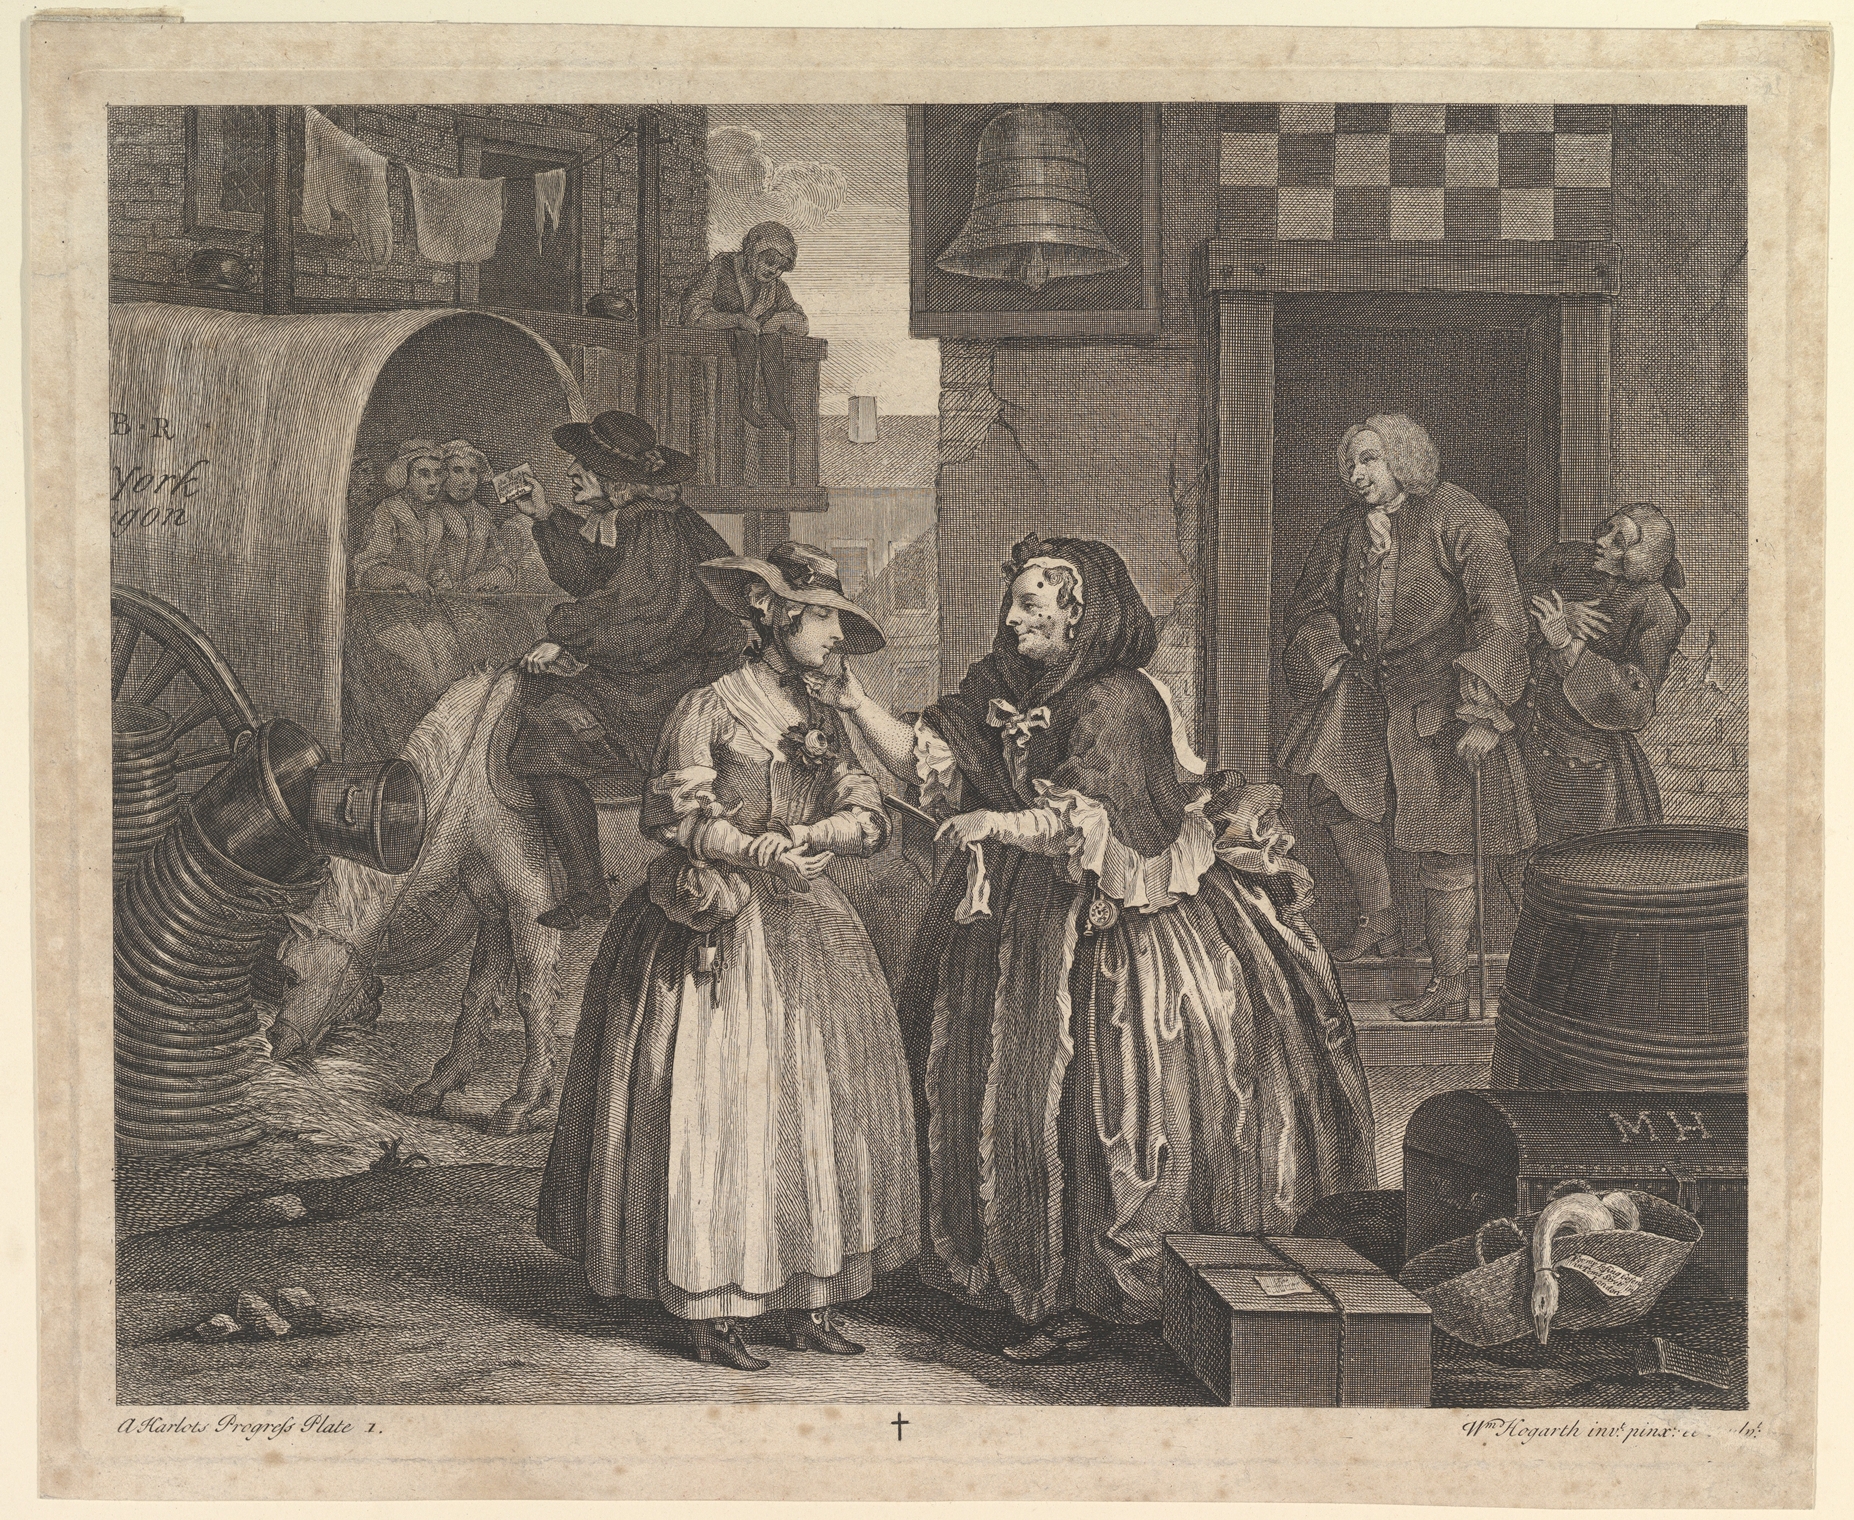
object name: print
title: A Harlot's Progress, Plate 1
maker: william hogarth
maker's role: artist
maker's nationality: british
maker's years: 1697-1764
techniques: engraving, etching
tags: men,women,horses